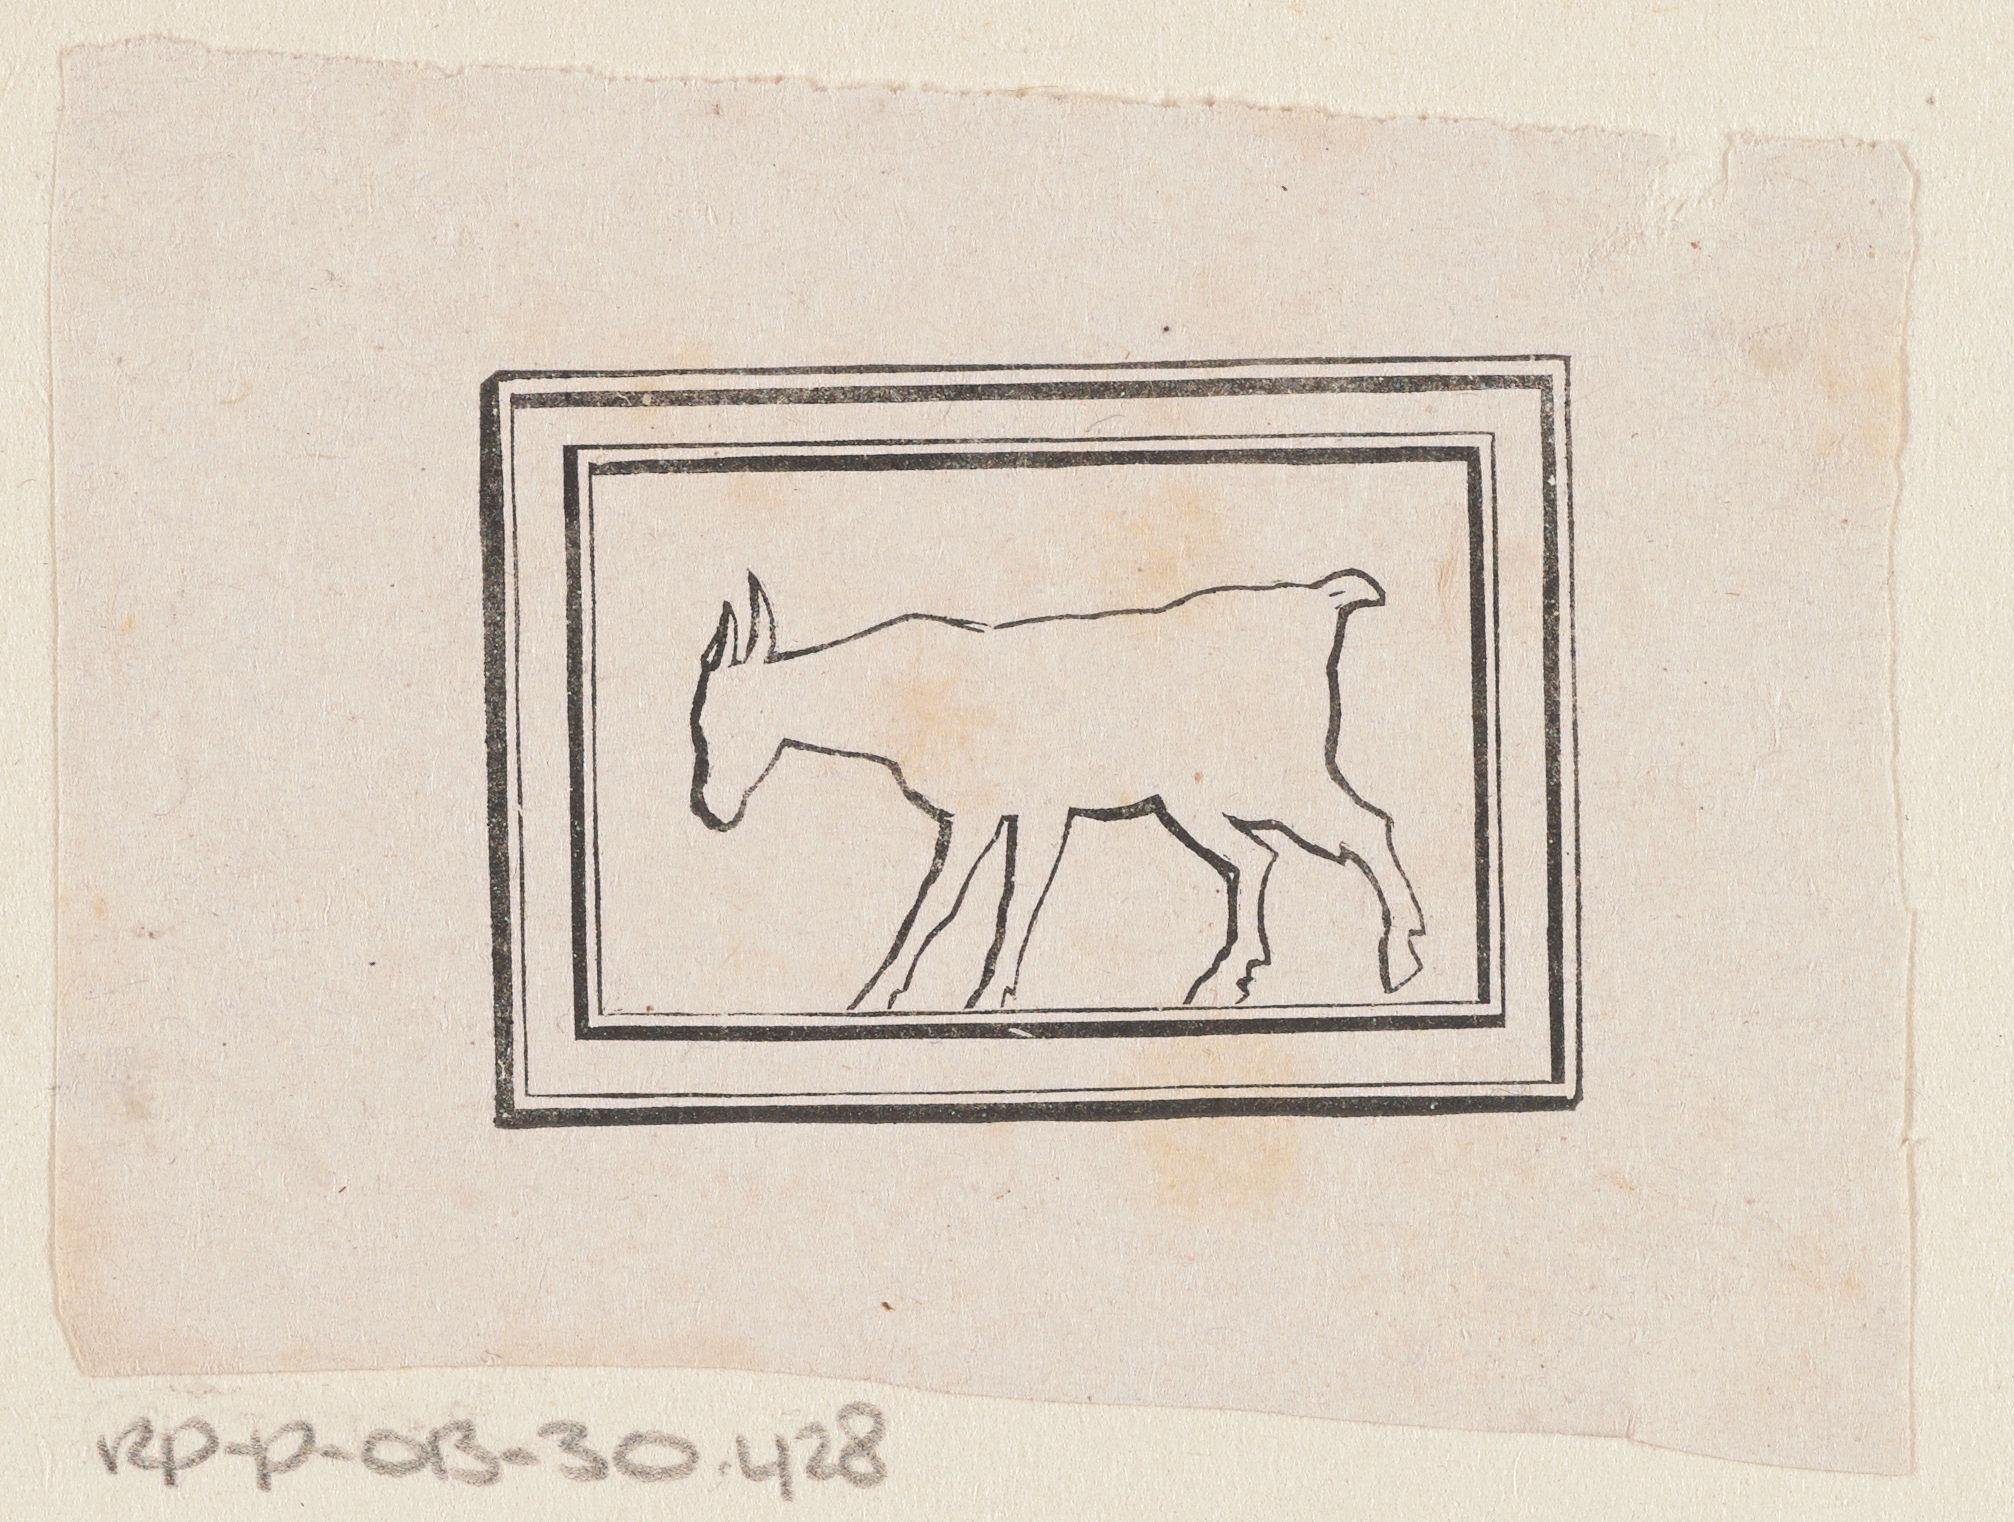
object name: print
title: Vignet met de contour van een bok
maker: isaac weissenbruch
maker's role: print maker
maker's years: 1826-1912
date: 1836-1912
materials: paper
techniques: engraving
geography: netherlands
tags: goat, vignette